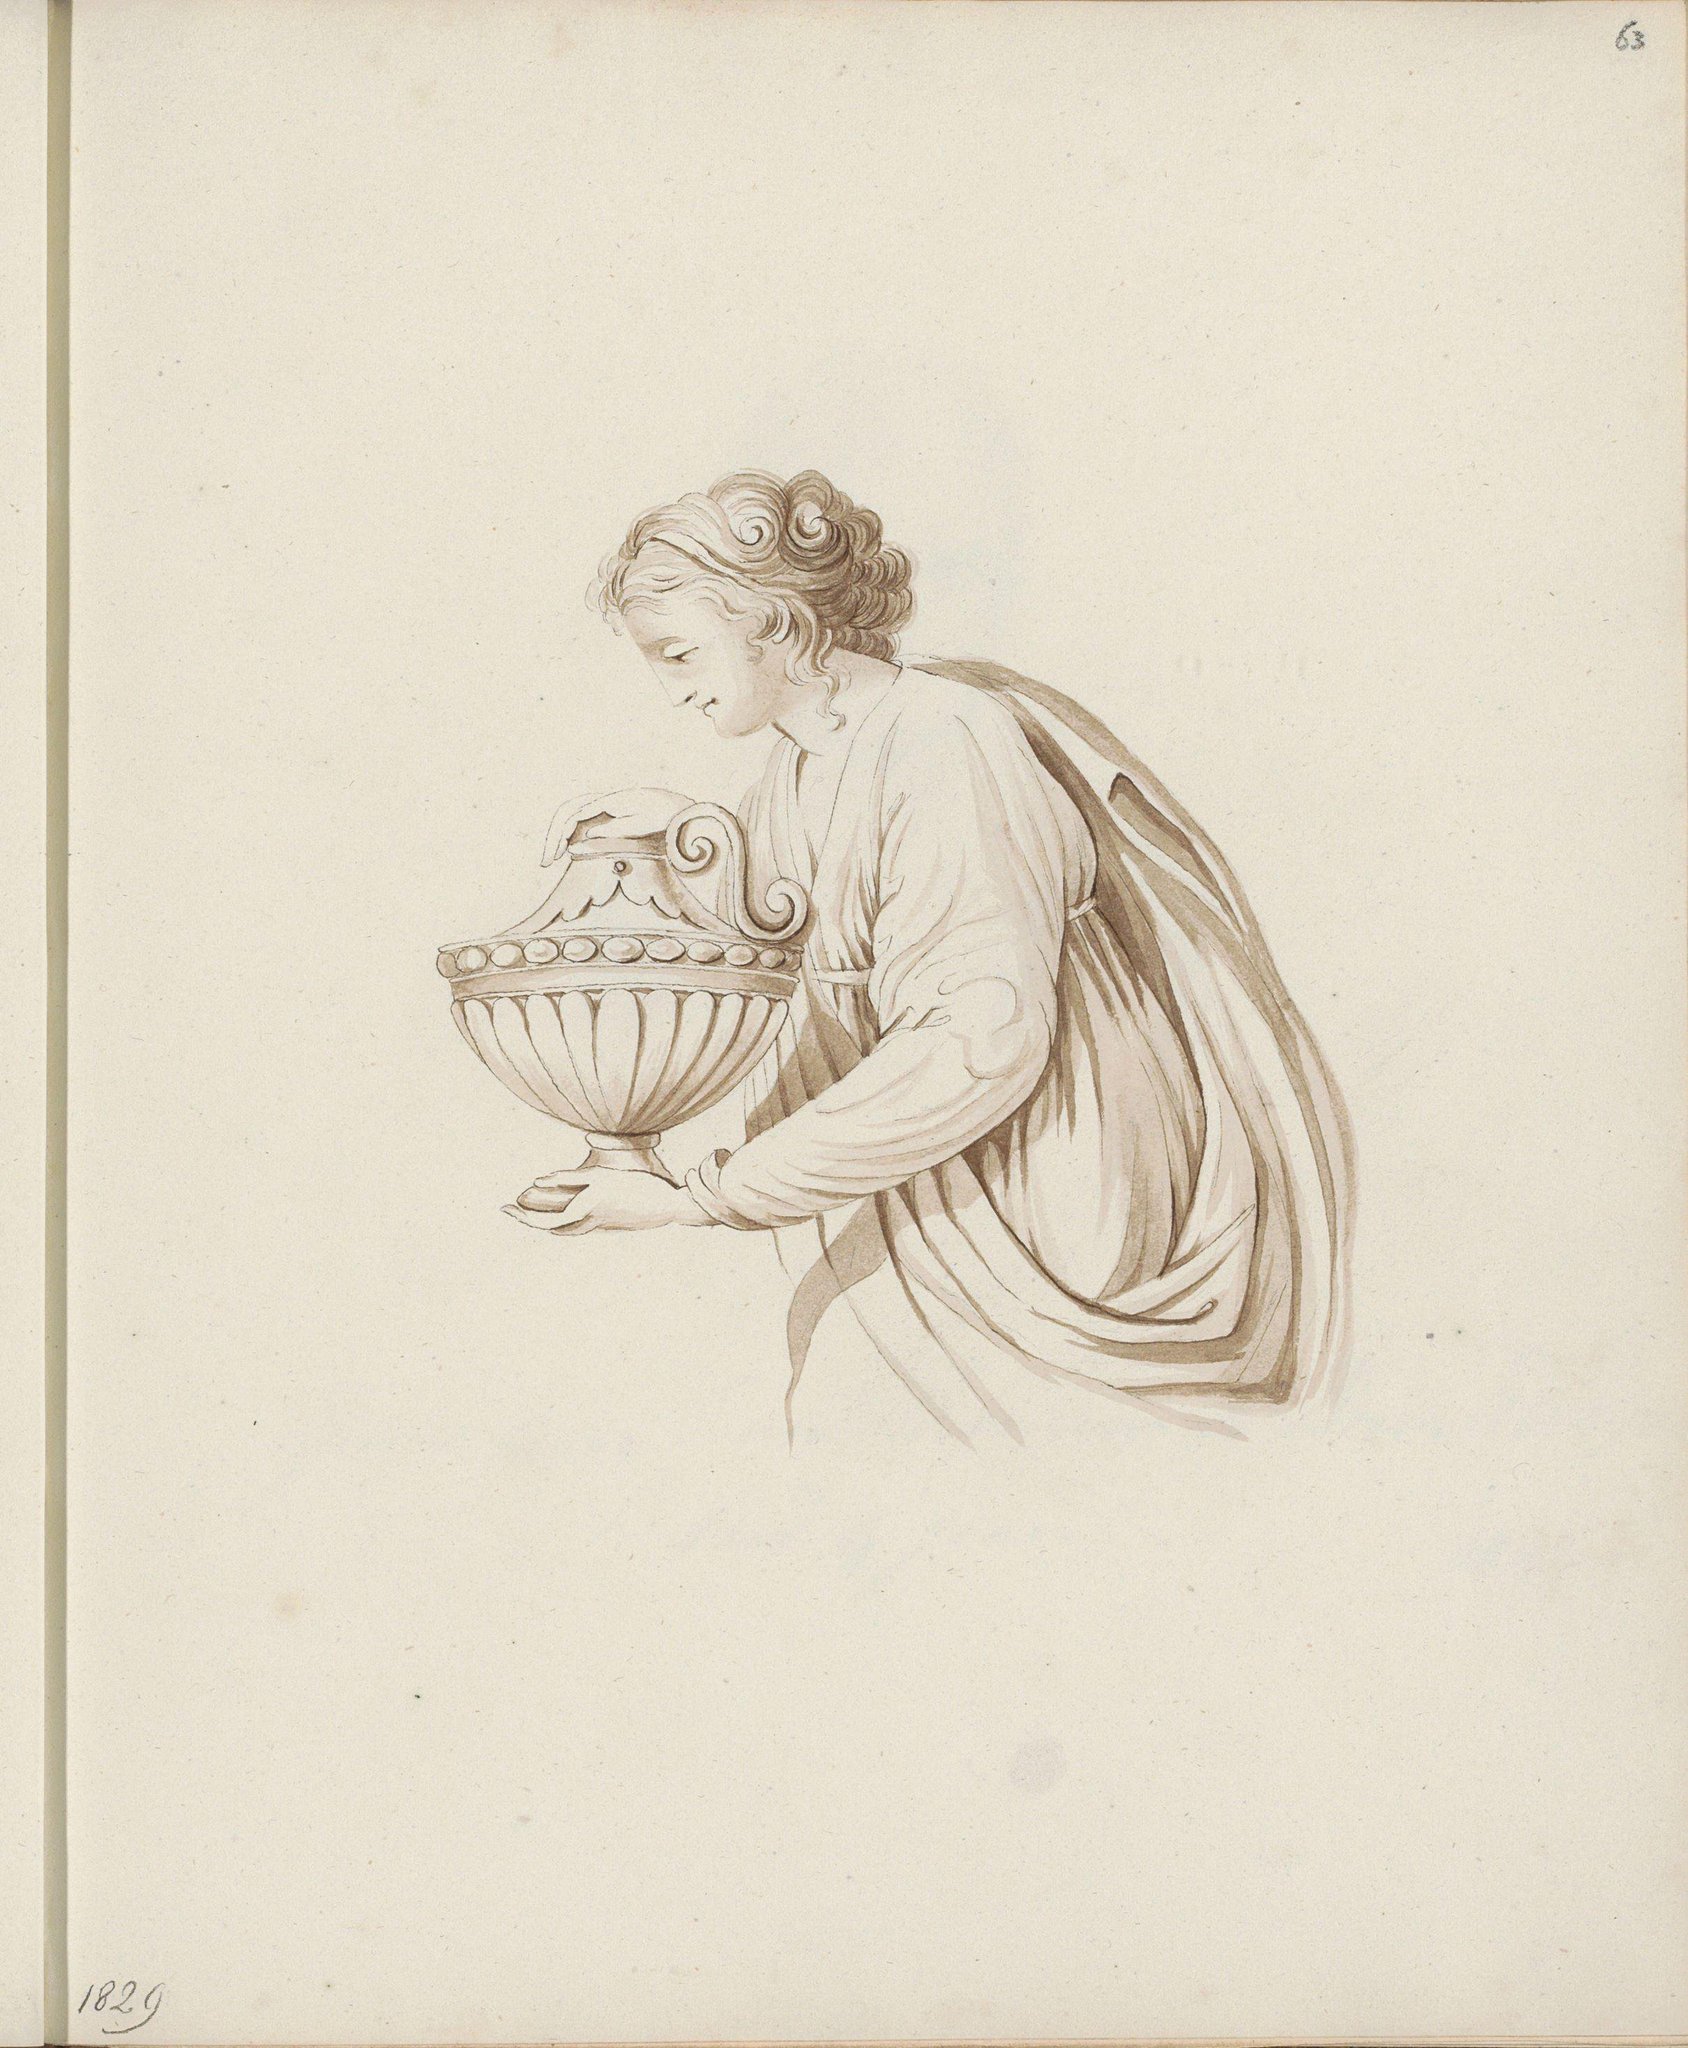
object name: sketchbook leaf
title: Vrouw die een ornamentele vaas met deksel draagt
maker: jonkvrouw elisabeth kemper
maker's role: draughtsman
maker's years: 1799-1871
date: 1829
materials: ink, paper, pencil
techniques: brush, pen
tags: carrying something, container of stone: stone vase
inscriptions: date: ‘1829’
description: De vrouw draagt een toga en buigt licht voorover. Blad 63 recto uit een schetsboek met 94 bladen.